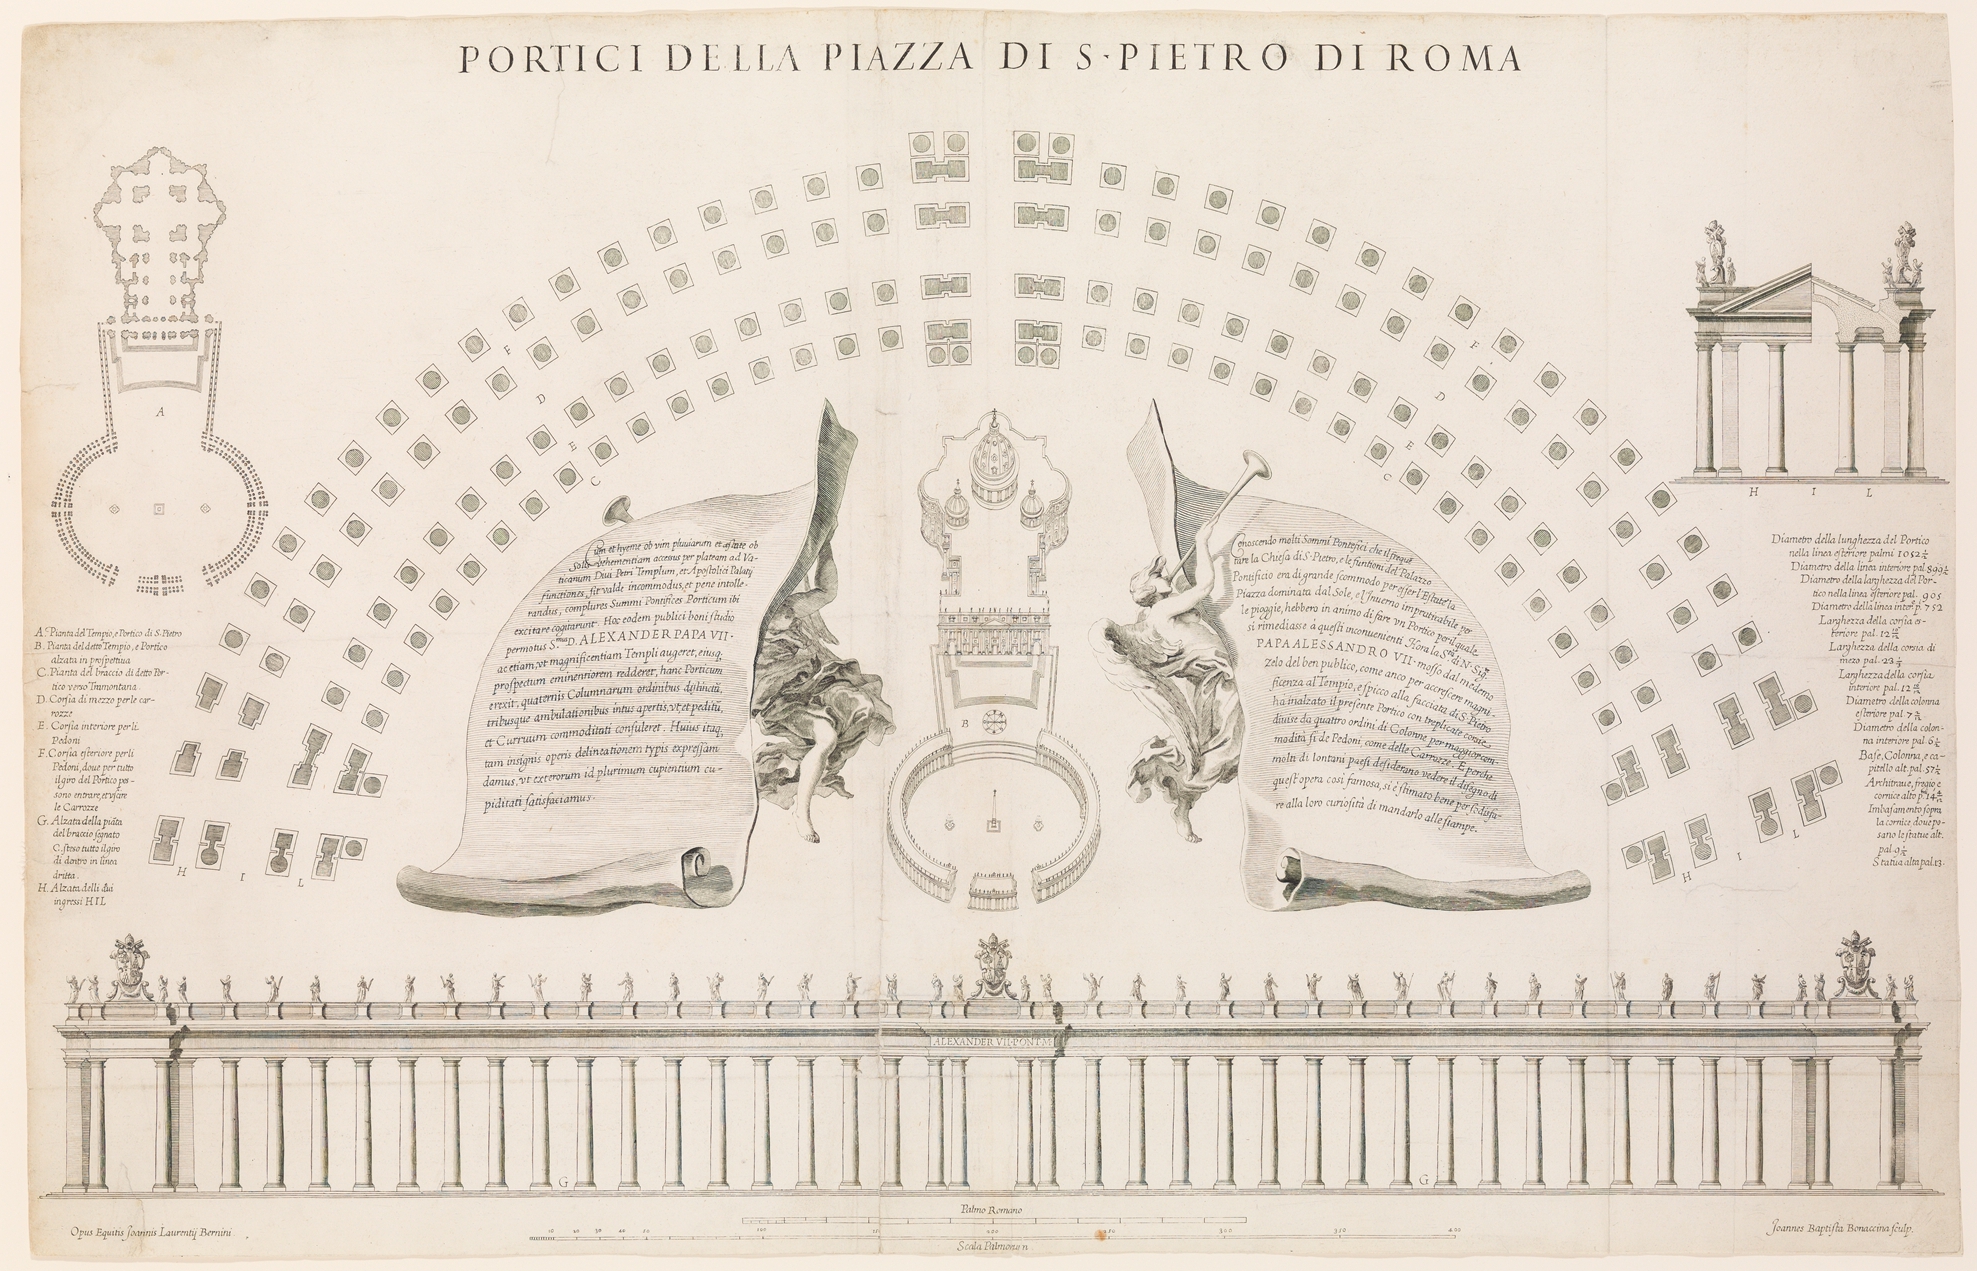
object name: print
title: Portici della piazza di S. Pietro di Roma. Plate 44 from the Album 'Basilica di S. Pietro in Vaticano'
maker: giovanni battista bonacina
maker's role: artist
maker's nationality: italian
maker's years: 1620-1670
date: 1656-1667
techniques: engraving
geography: rome?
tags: architecture